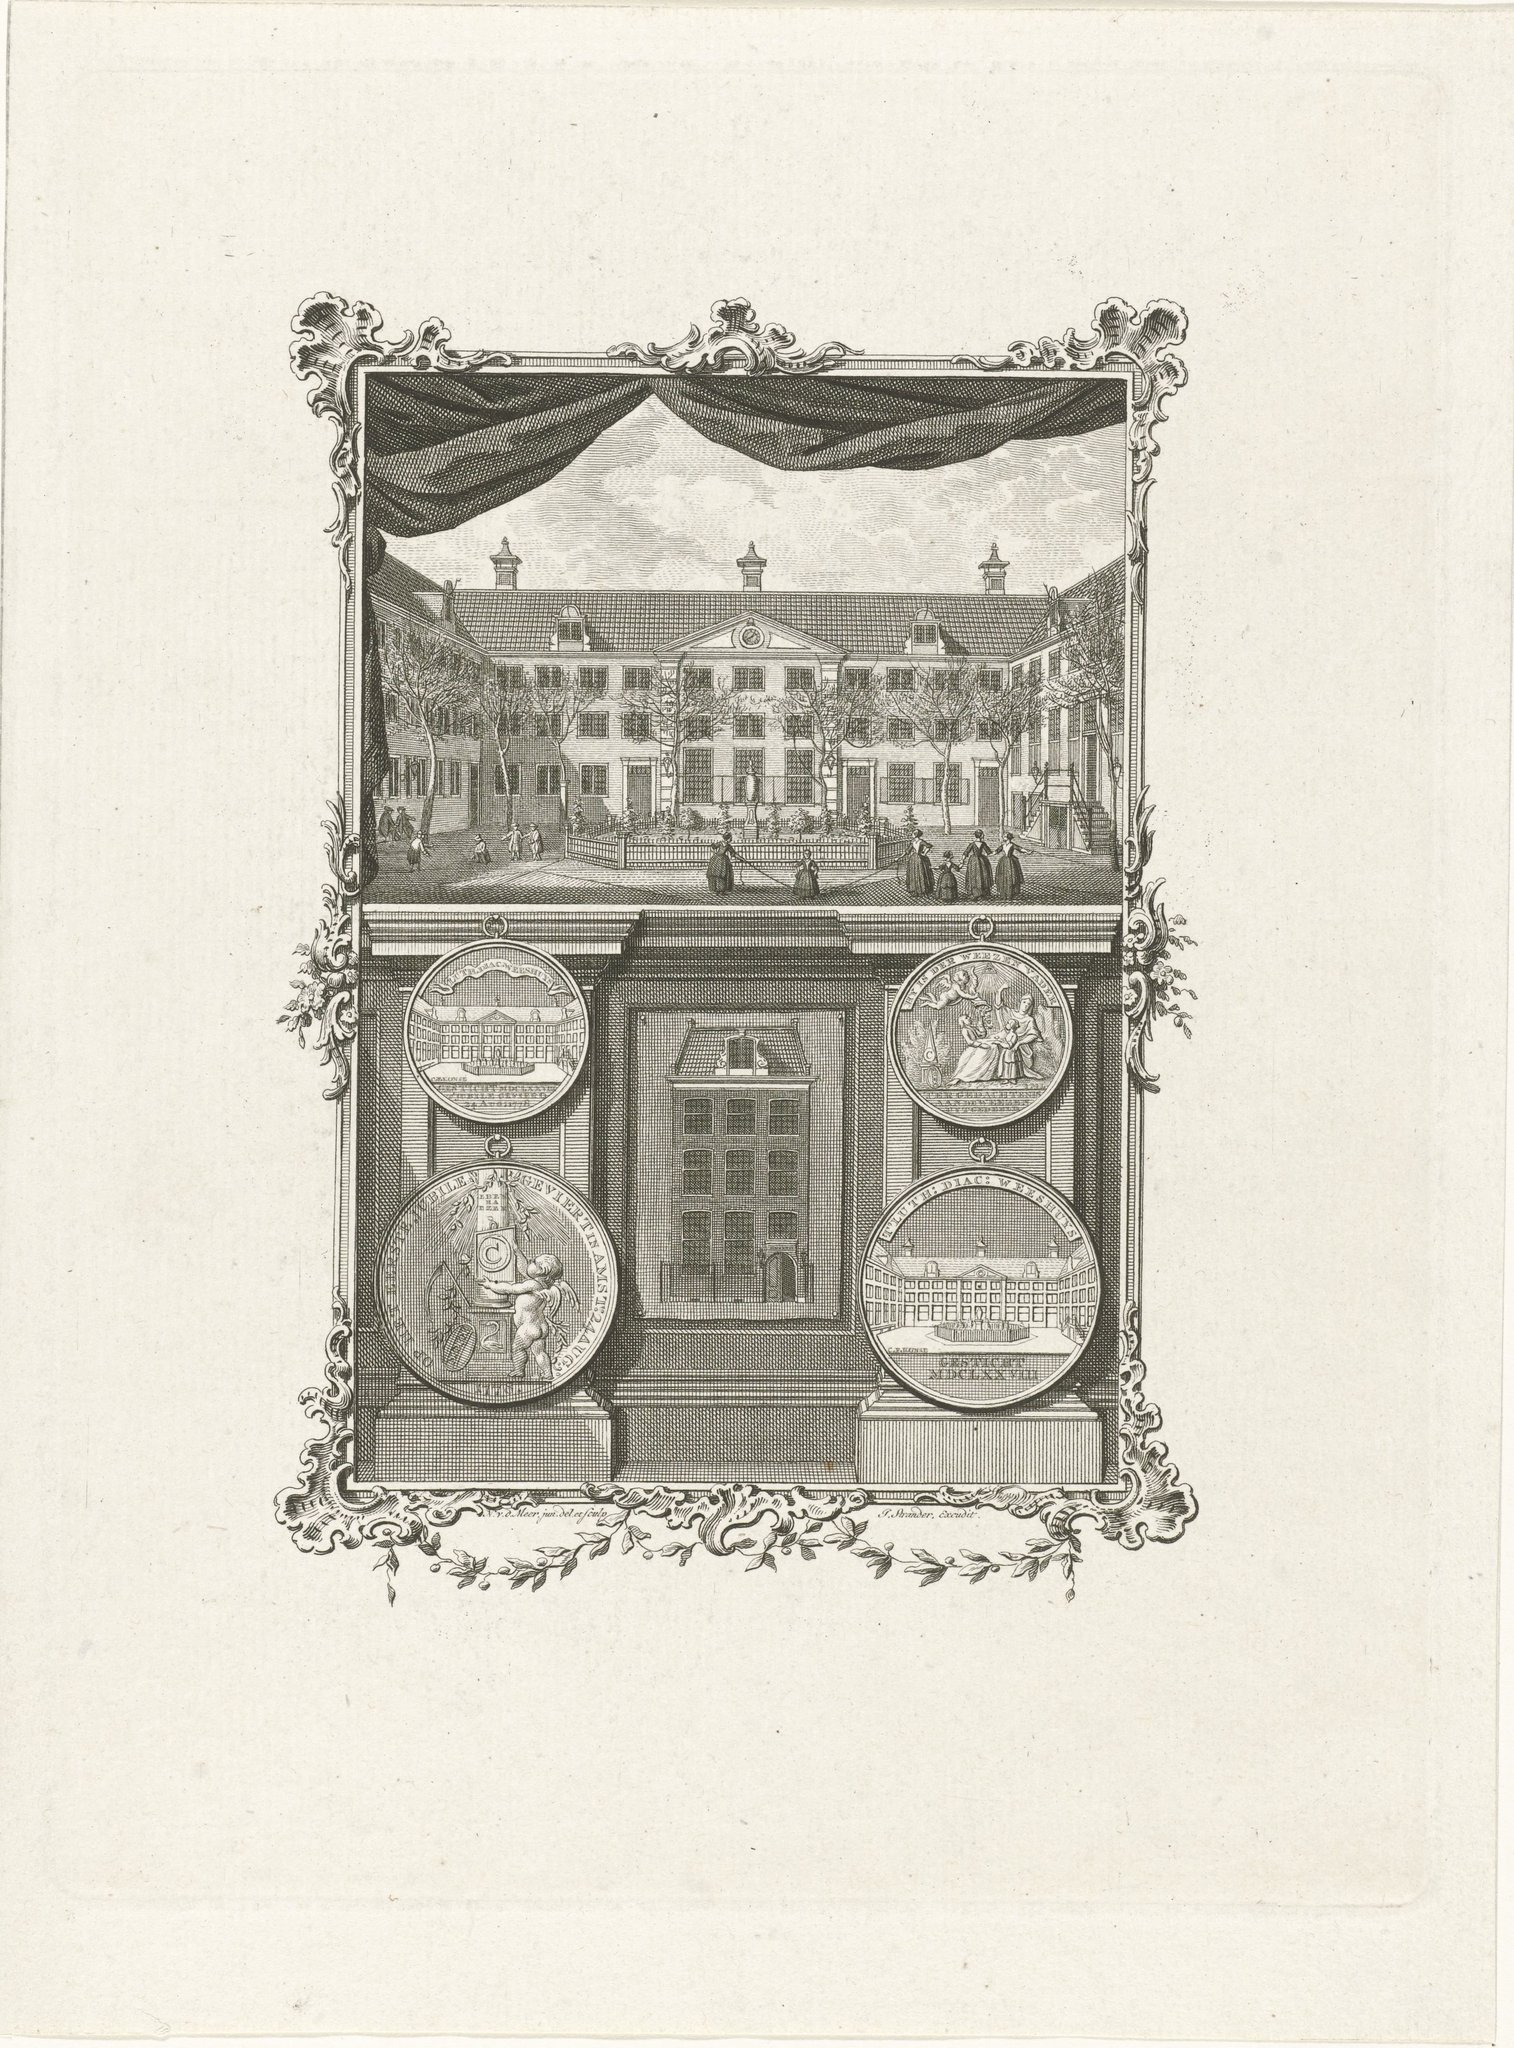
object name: print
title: Gezicht op de binnenplaats van het Lutherse Diaconieweeshuis te Amsterdam en penningen voor het eerste eeuwfeest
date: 1778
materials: paper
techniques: engraving, etching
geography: amsterdam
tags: medal (considered as a piece of sculpture, regardless of its specific function)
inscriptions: collector's mark: Lugt 2228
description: Gebruikt als illustratie in: Jan Hendrik Vorstius, Redevoering op het eerste eeuwfeest van het luthersche diakonie-weeshuis binnen Amsterdam. Amsterdam: Johannes Strander (II), 1778. Voor de afgebeelde penningen zie: NG-VG-1-2790 en NG-VG-1-2792.